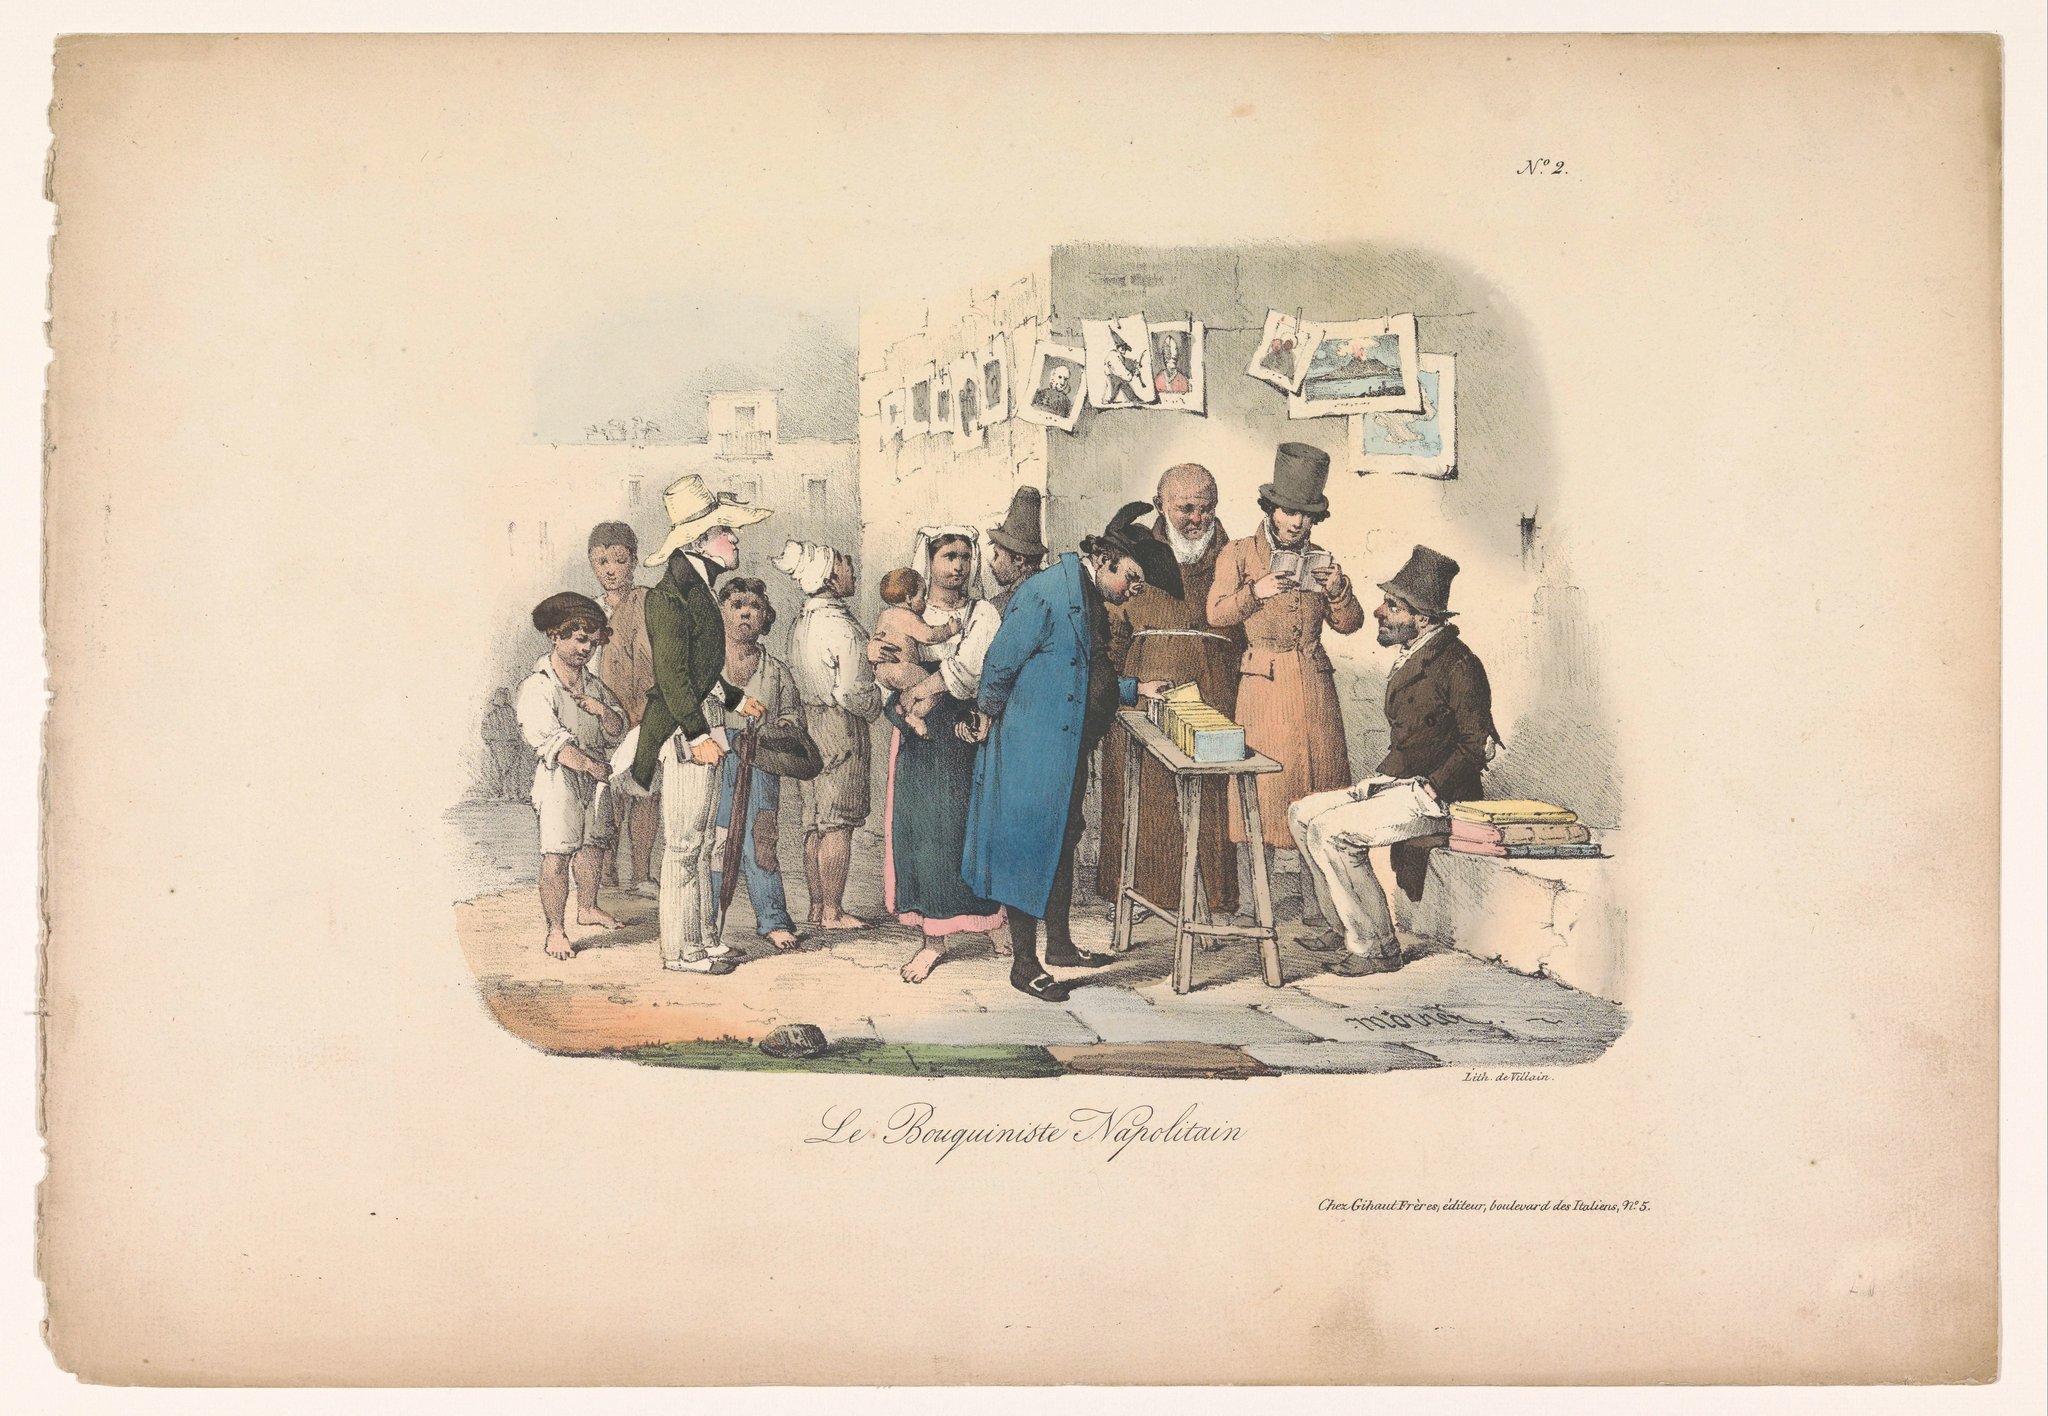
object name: print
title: Le bouquiniste Napolitain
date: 1828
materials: paper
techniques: hand coloring, lithograph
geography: paris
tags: book-stall, kiosk, art dealer (+ graphic arts), street-trader, naples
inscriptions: collector's mark: Lugt 2228, collector's mark: Lugt 4779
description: Op zit een boekhandelaar op een muur achter zijn boekenkraam. Twee mannen met hoeden en een geestelijke bekijken het aanbod. Aan een koord aan de muur hangen prenten. Op het plein enkele mannen, vrouwen en kinderen.